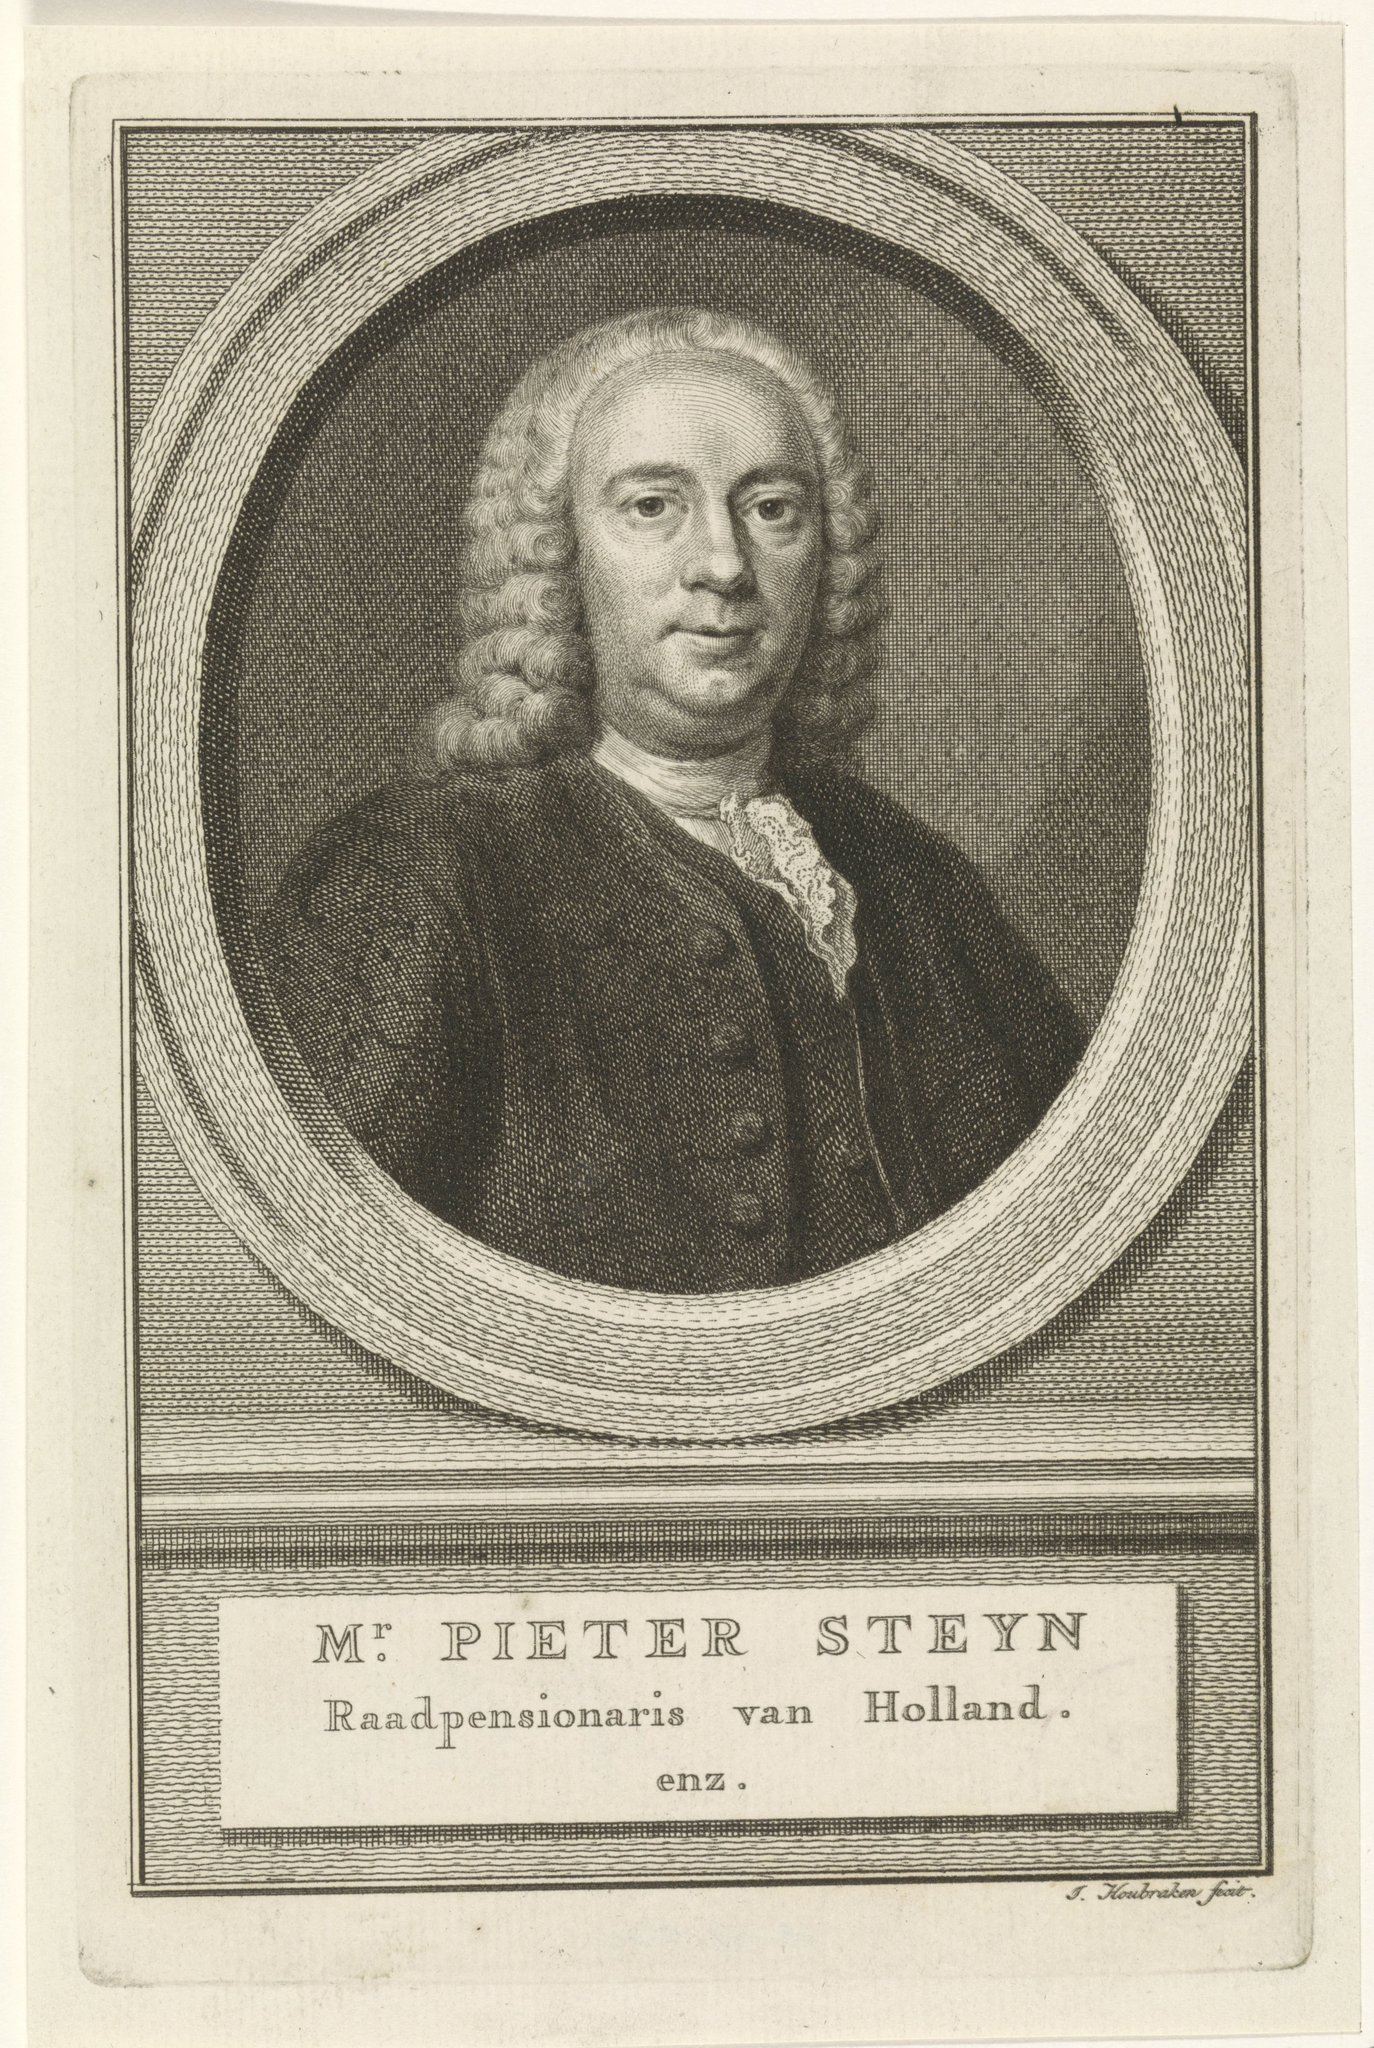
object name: print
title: Portret van Pieter Steijn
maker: jacob houbraken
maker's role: draughtsman, print maker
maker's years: 1698-1780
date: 1749-1780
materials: paper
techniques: engraving, etching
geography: amsterdam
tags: pieter steijn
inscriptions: collector's mark: Lugt 240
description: Buste naar rechts van Pieter Steijn in een ovaal. Het portret rust op een piëdestal waarop zijn naam en gegevens in drie regels in het Nederlands.